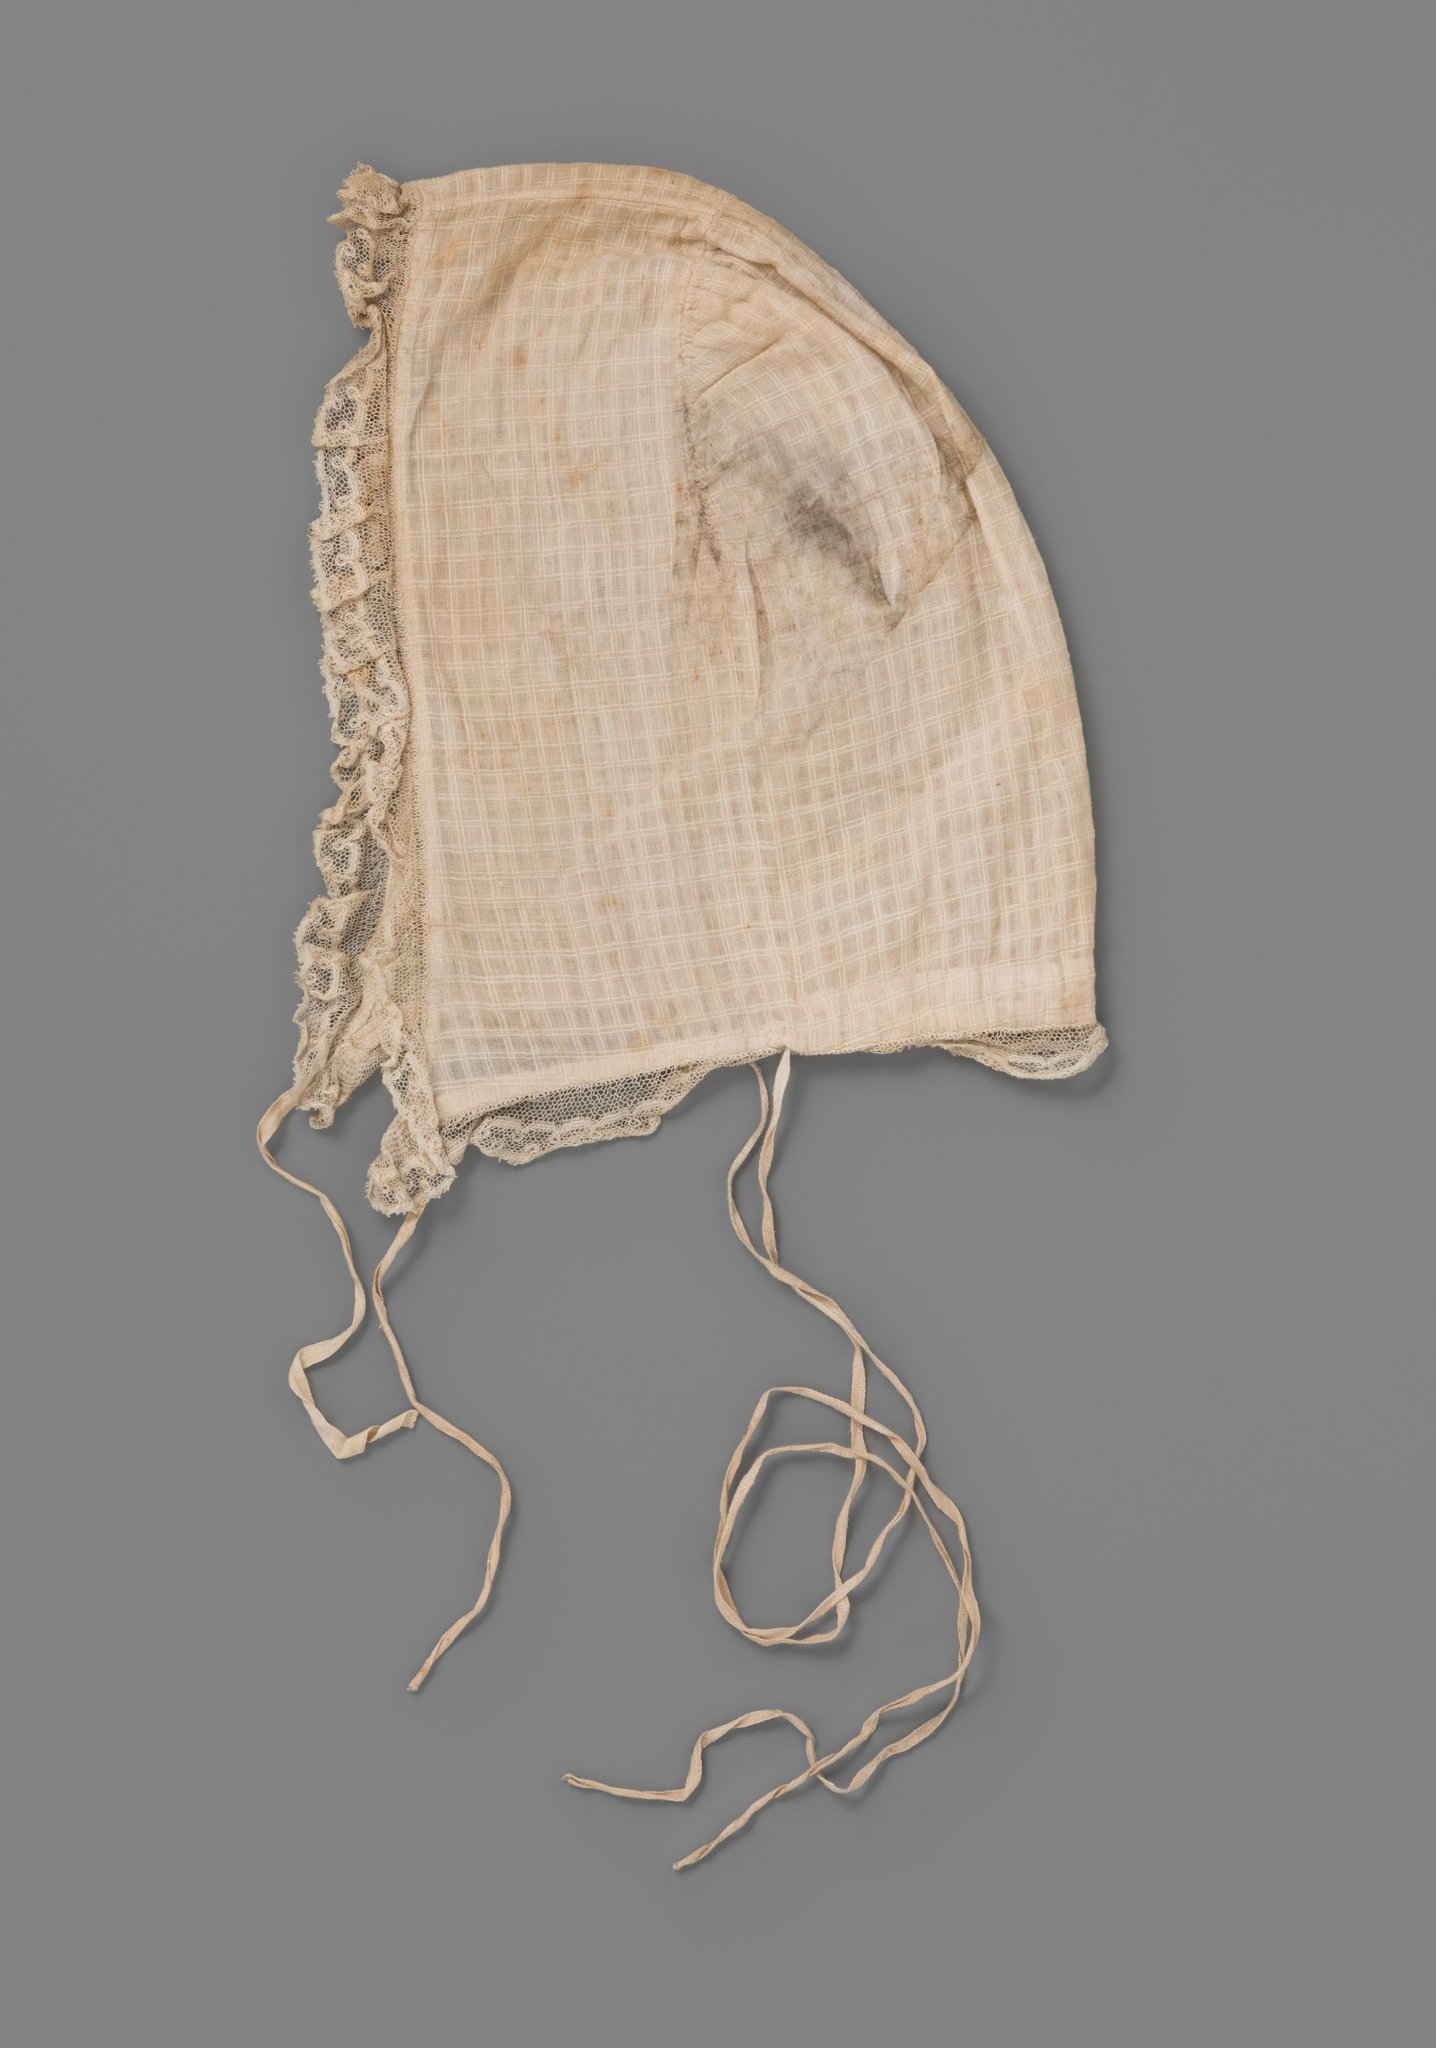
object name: streekdracht, streekkleding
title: Muts van katoen met ingeweven ruiten en versierd met Rijsselse kant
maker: Anonymous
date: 1800-1815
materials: cotton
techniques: lace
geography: friesland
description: Muts van katoen met ingeweven ruiten en versierd met een strook Rijsselse kant. Mogelijk streekdracht.